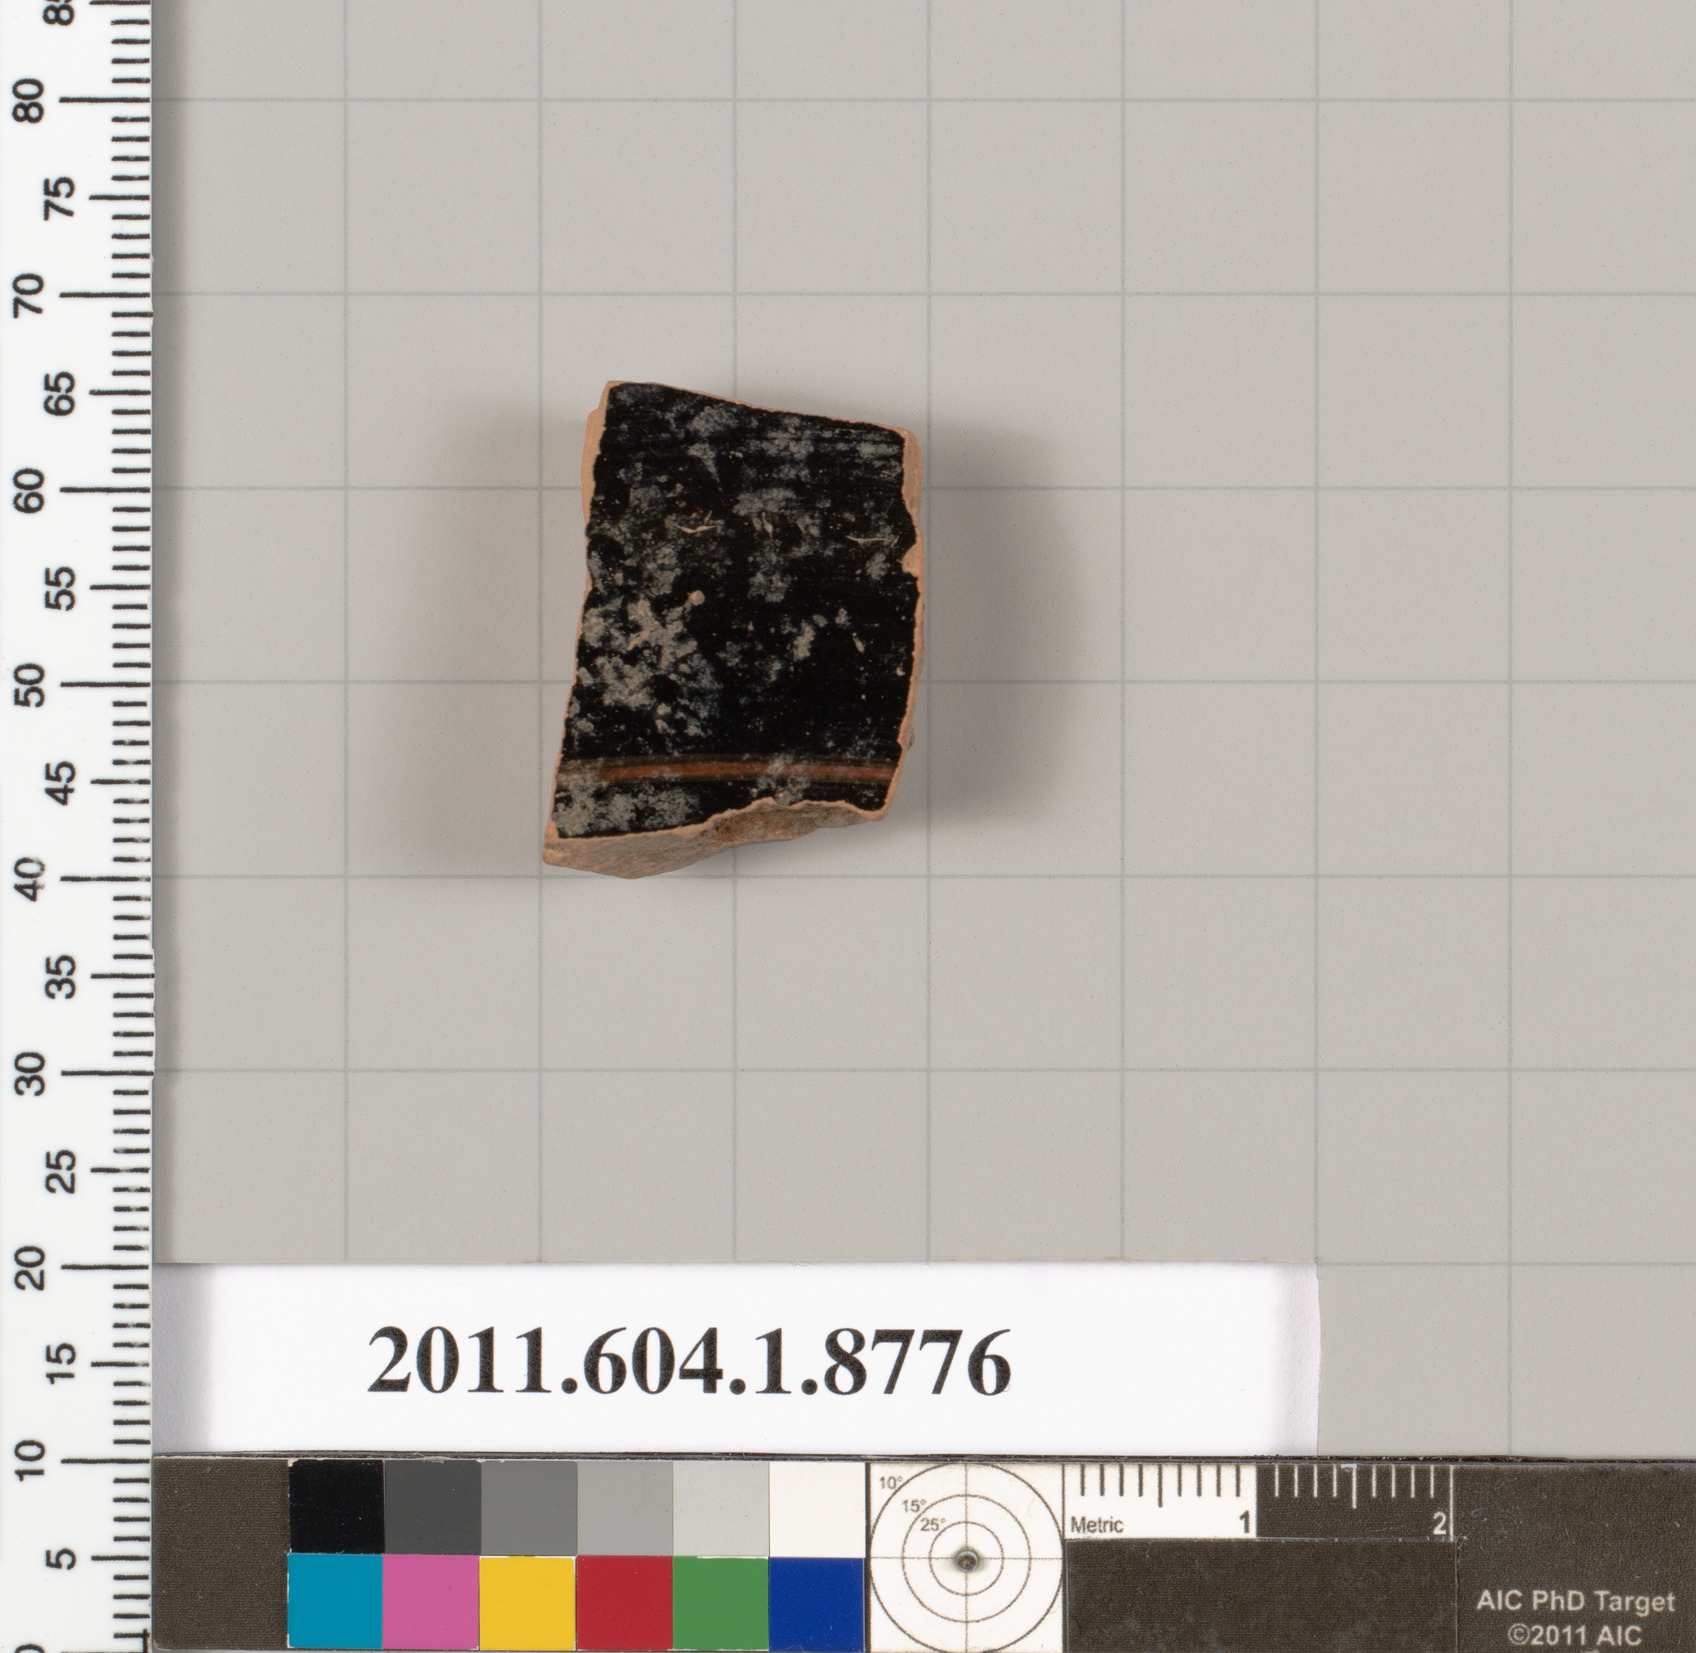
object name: kylix fragment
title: Terracotta fragment of a stemless kylix (drinking cup)?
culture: greek, attic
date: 475-451 BCE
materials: terracotta